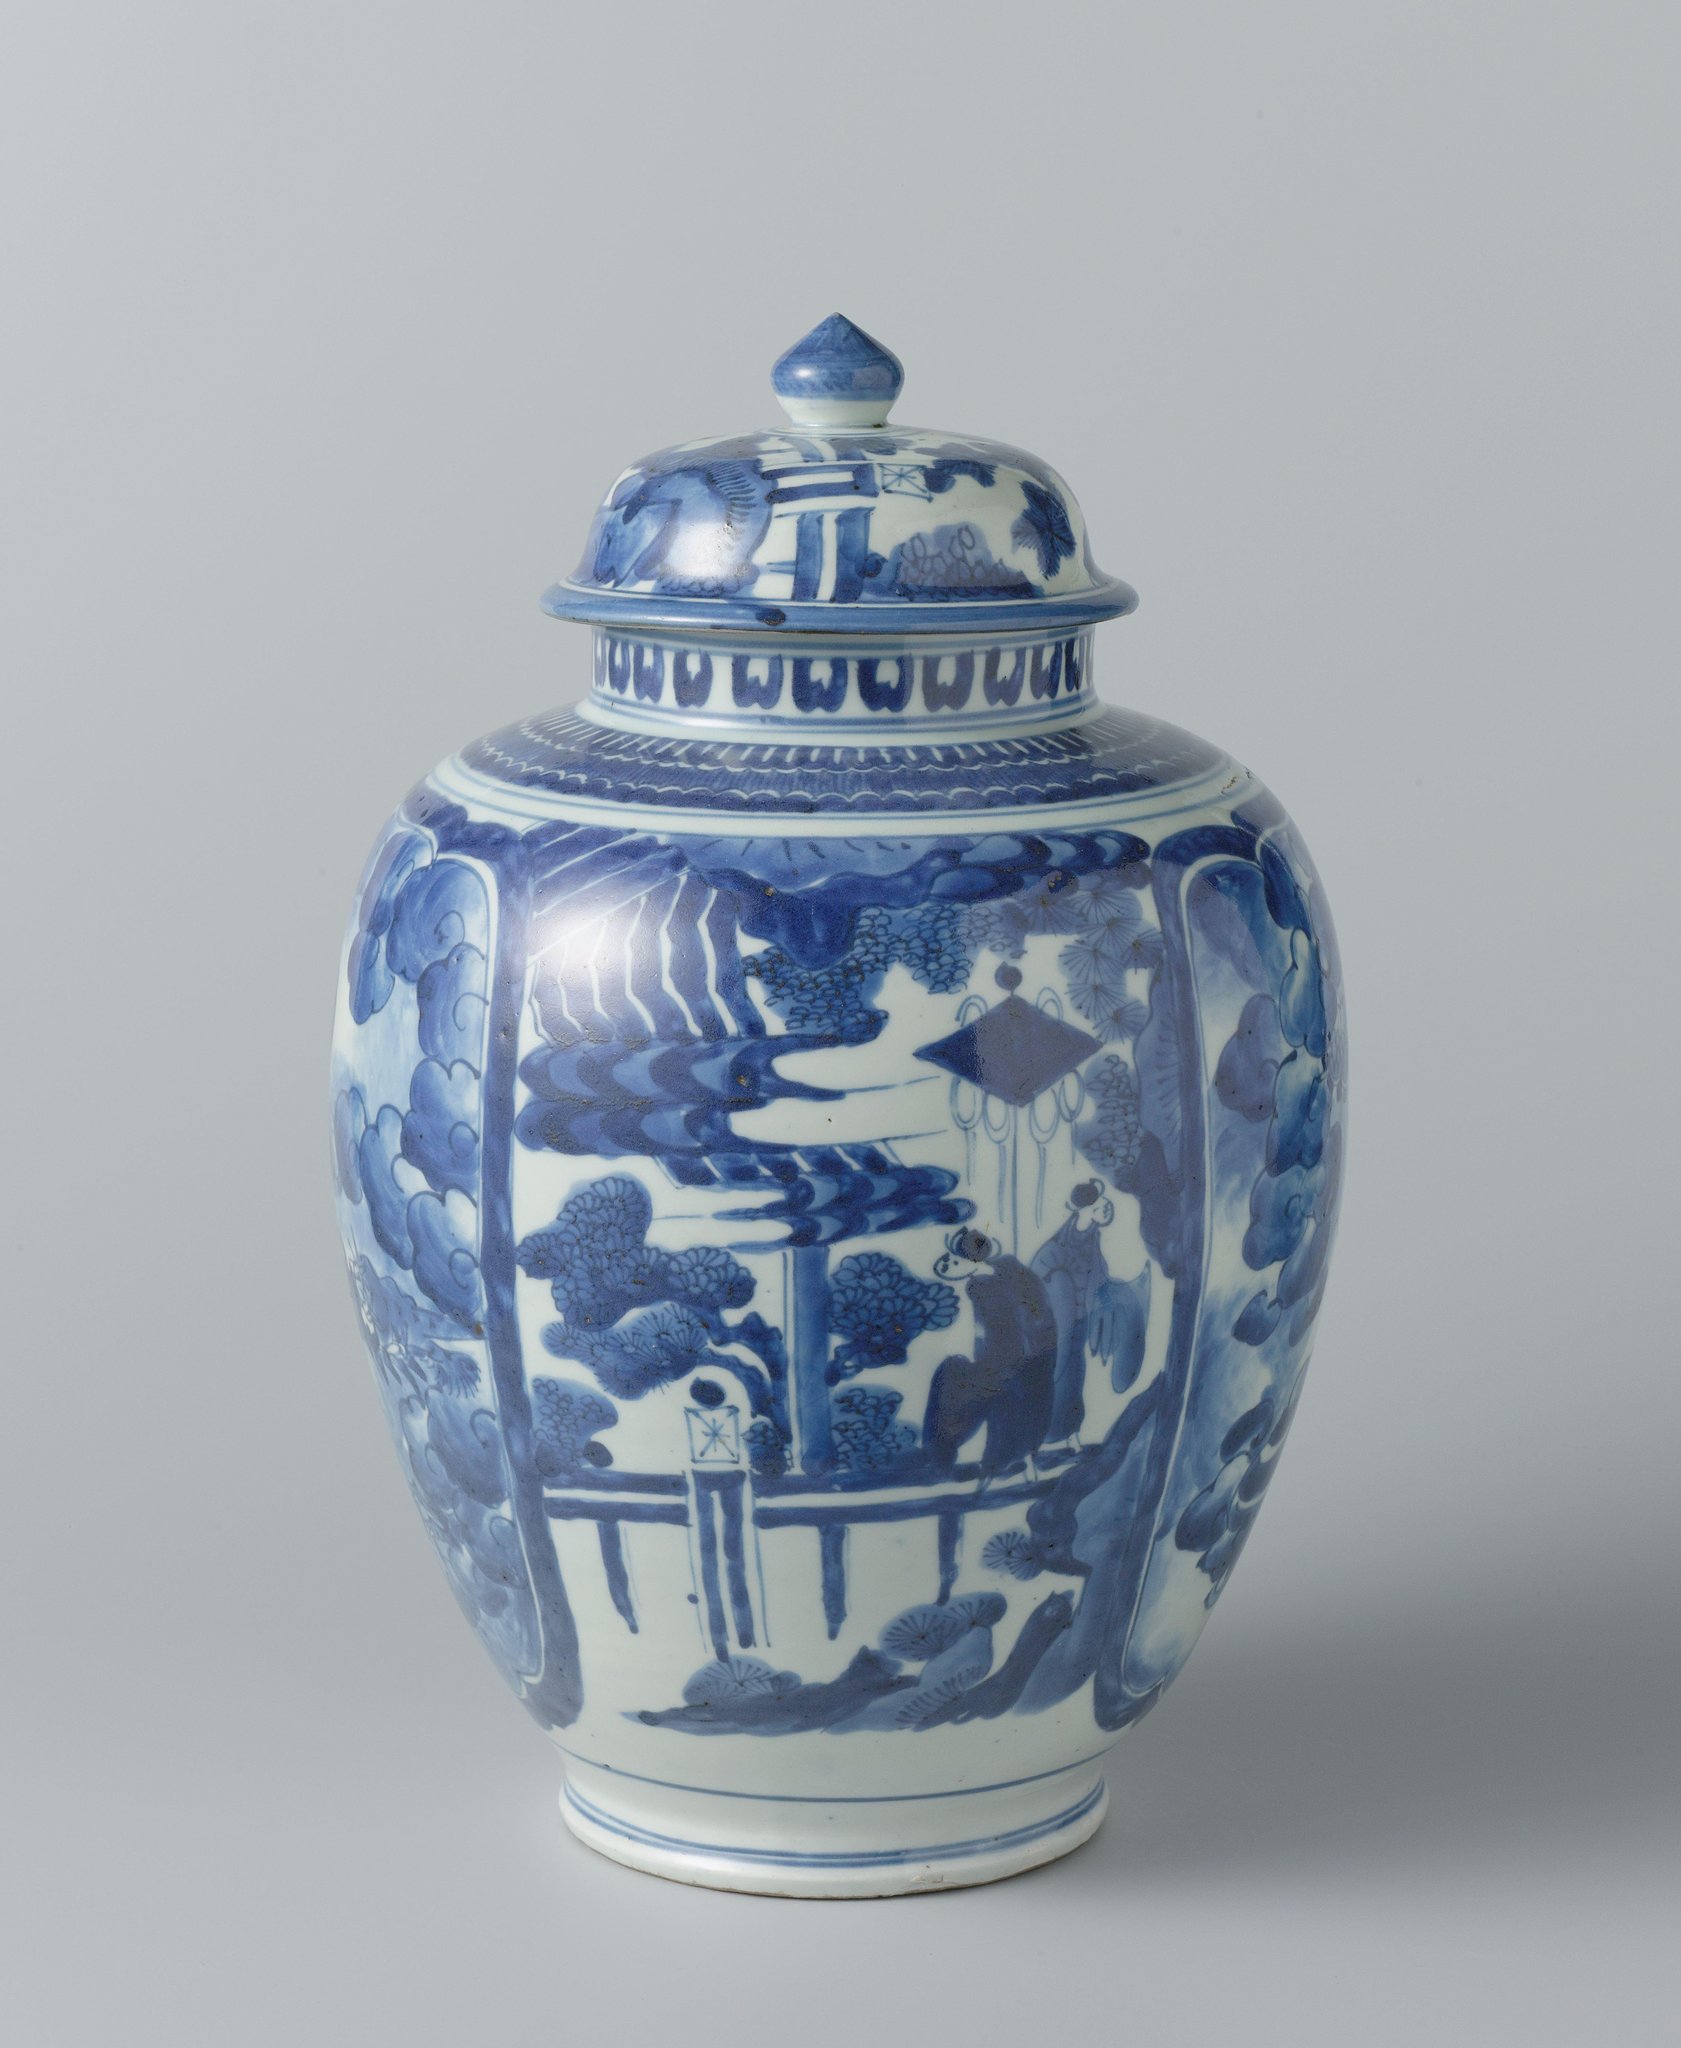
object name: covered jar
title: Ovoid covered jar with figures in a landscape and panels with dragons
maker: Anonymous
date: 1670-1680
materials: cobalt, glaze, paint, porcelain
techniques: firing, turning, vitrification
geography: arita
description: Ei-vormige dekselpot met een korte, wijde hals en een klokvormige deksel met puntige dekselknop. Beschilderd in onderglazuur blauw met twee grote panelen met draken die in de wolken op een parel jagen. Tussen deze velden aan één zijde een landschap met een pijnboom en een hek, aan de andere zijde twee figuren in een landschap. Op het deksel een landschap.